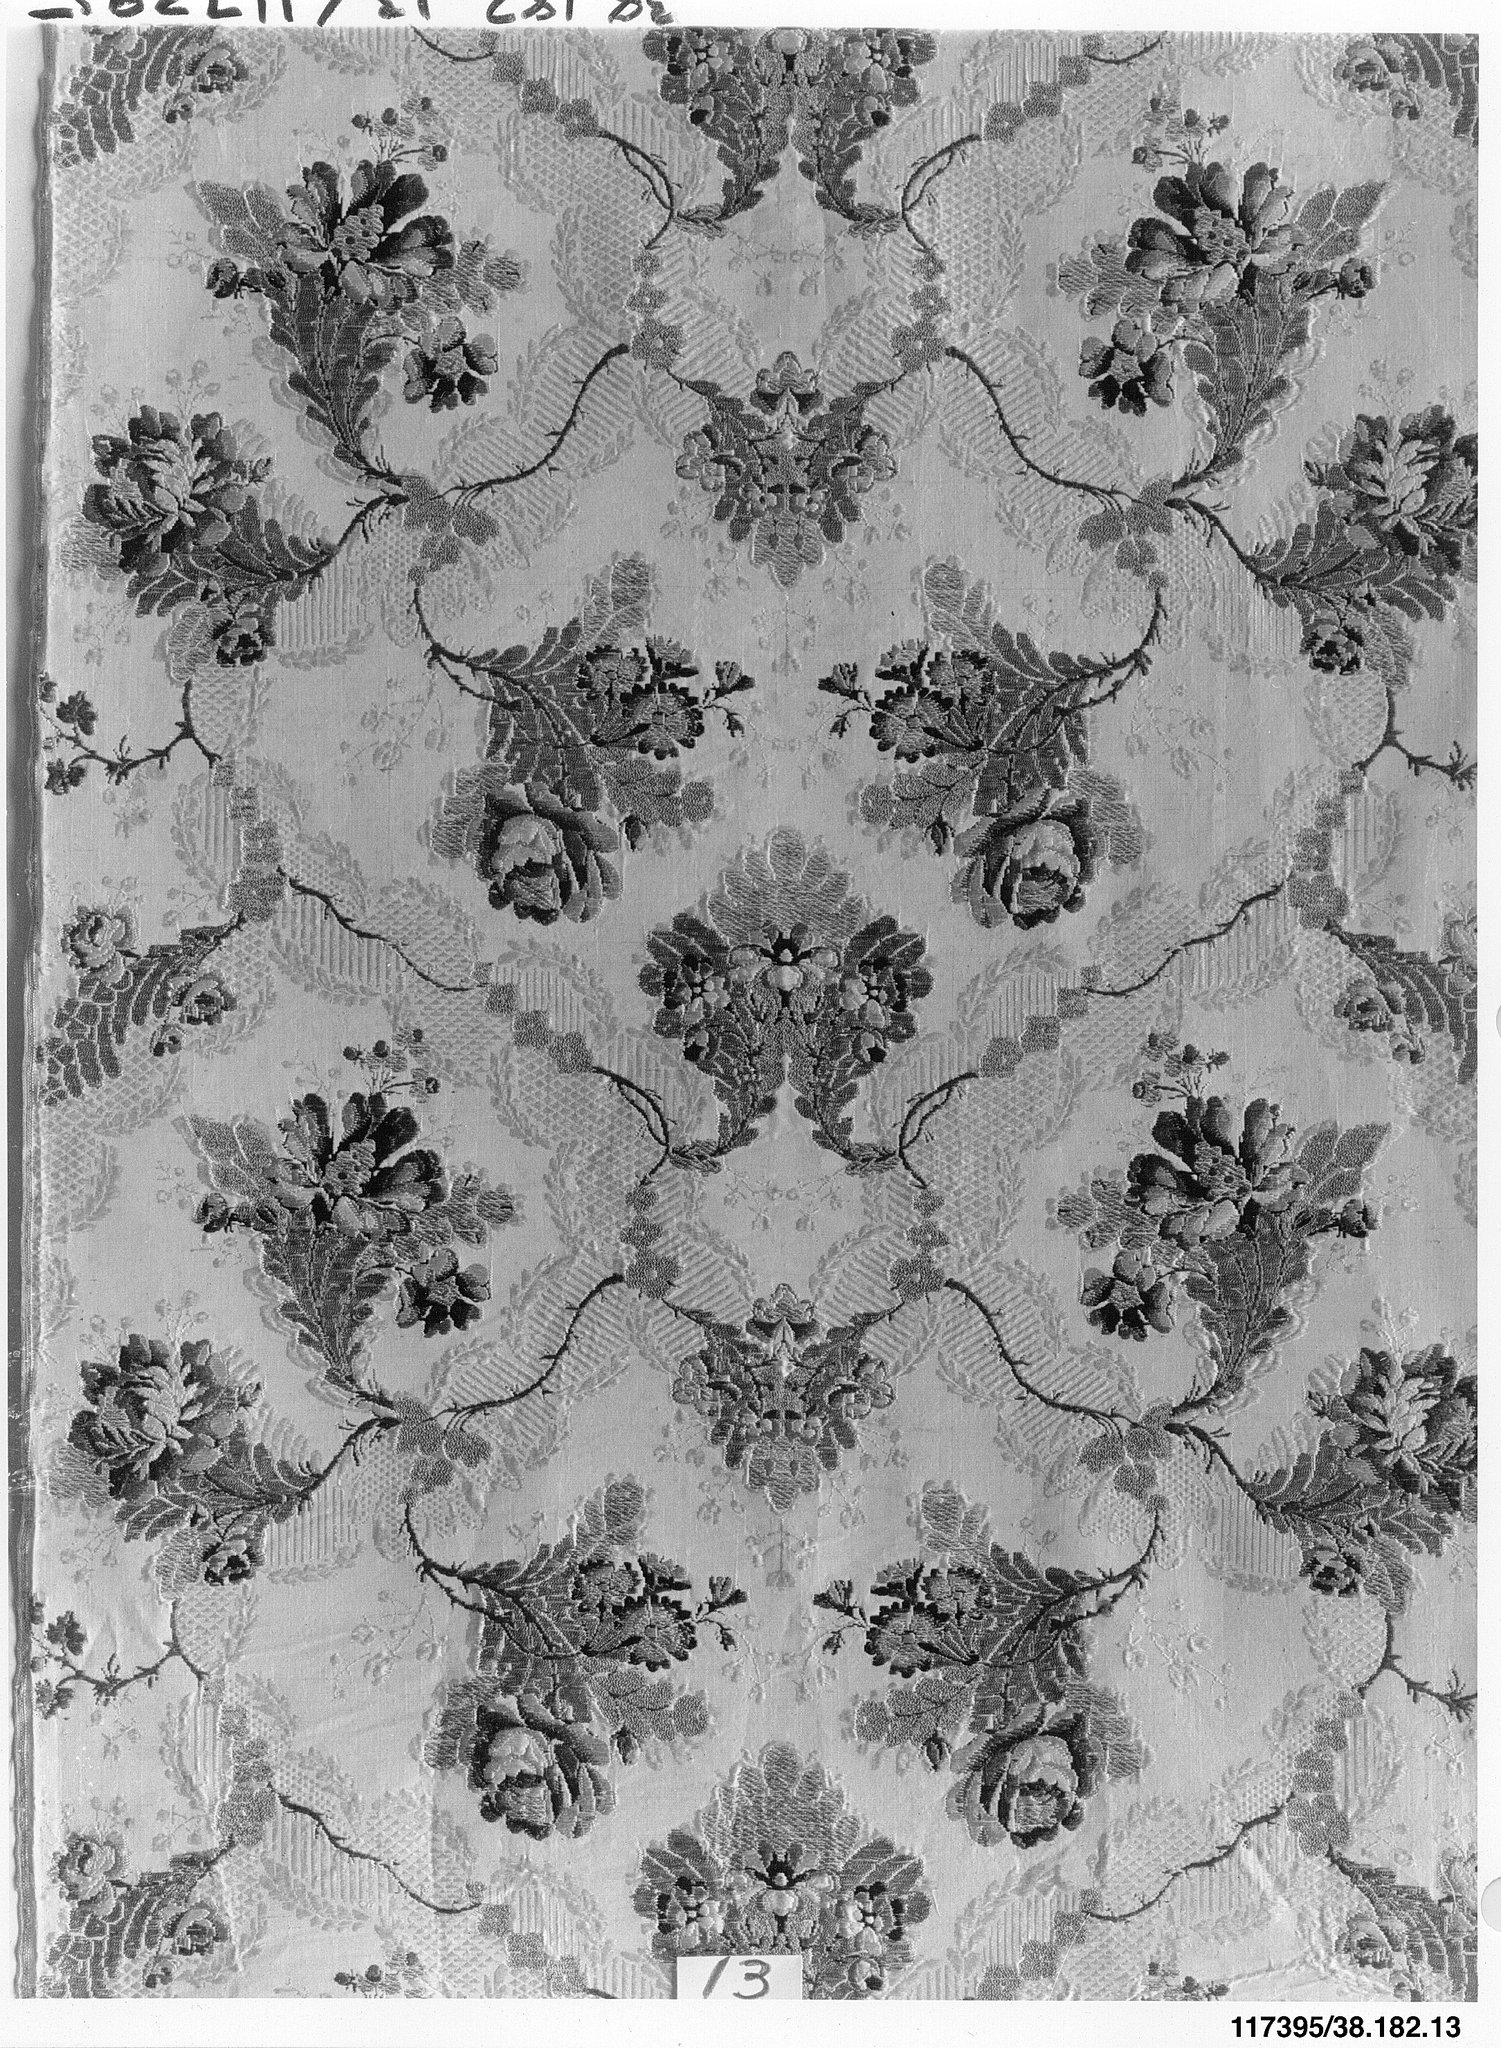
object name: piece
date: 1760-1770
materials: metal thread, silk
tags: flowers,leaves